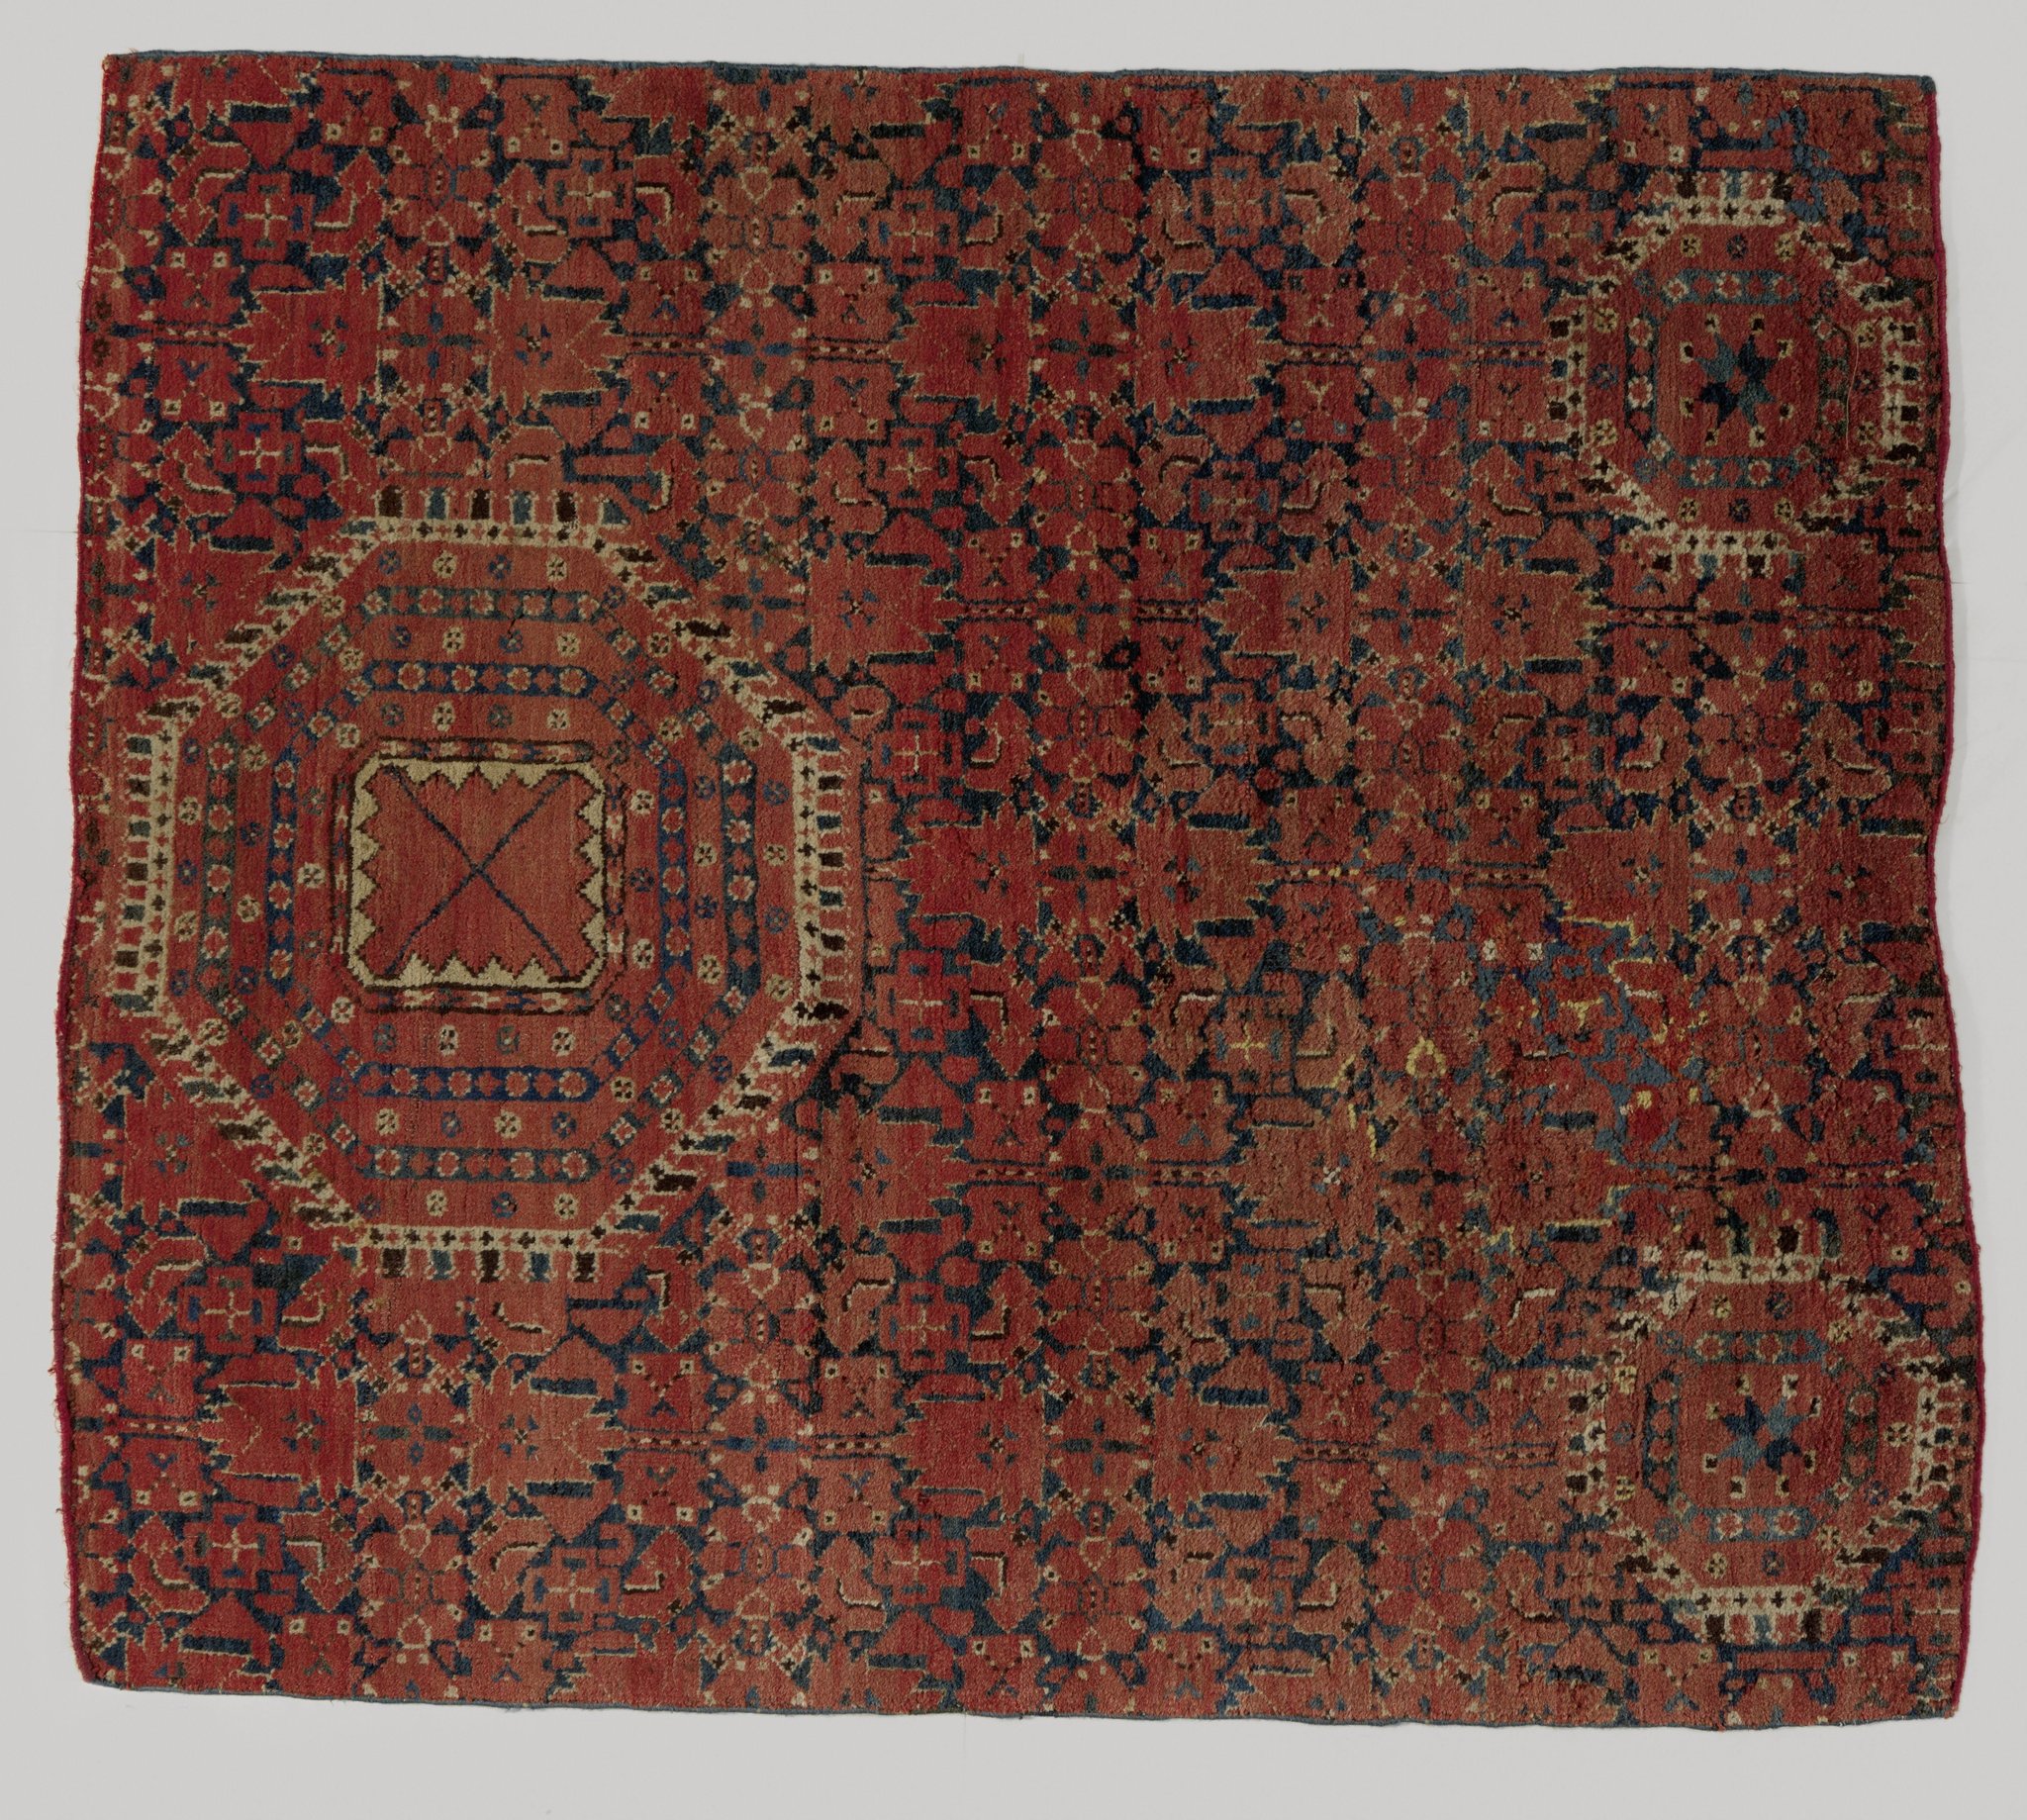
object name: fragment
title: Fragment van een Oosters tapijt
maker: Anonymous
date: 1800-1900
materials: animal fiber, wool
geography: beshir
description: Fragment van een Oosters tapijt, medaillonkleed. In het middenveld een groot middenmedaillon en bovenaan twee kleinere. Het veld is versierd met een heratipatroon. Geen randen.